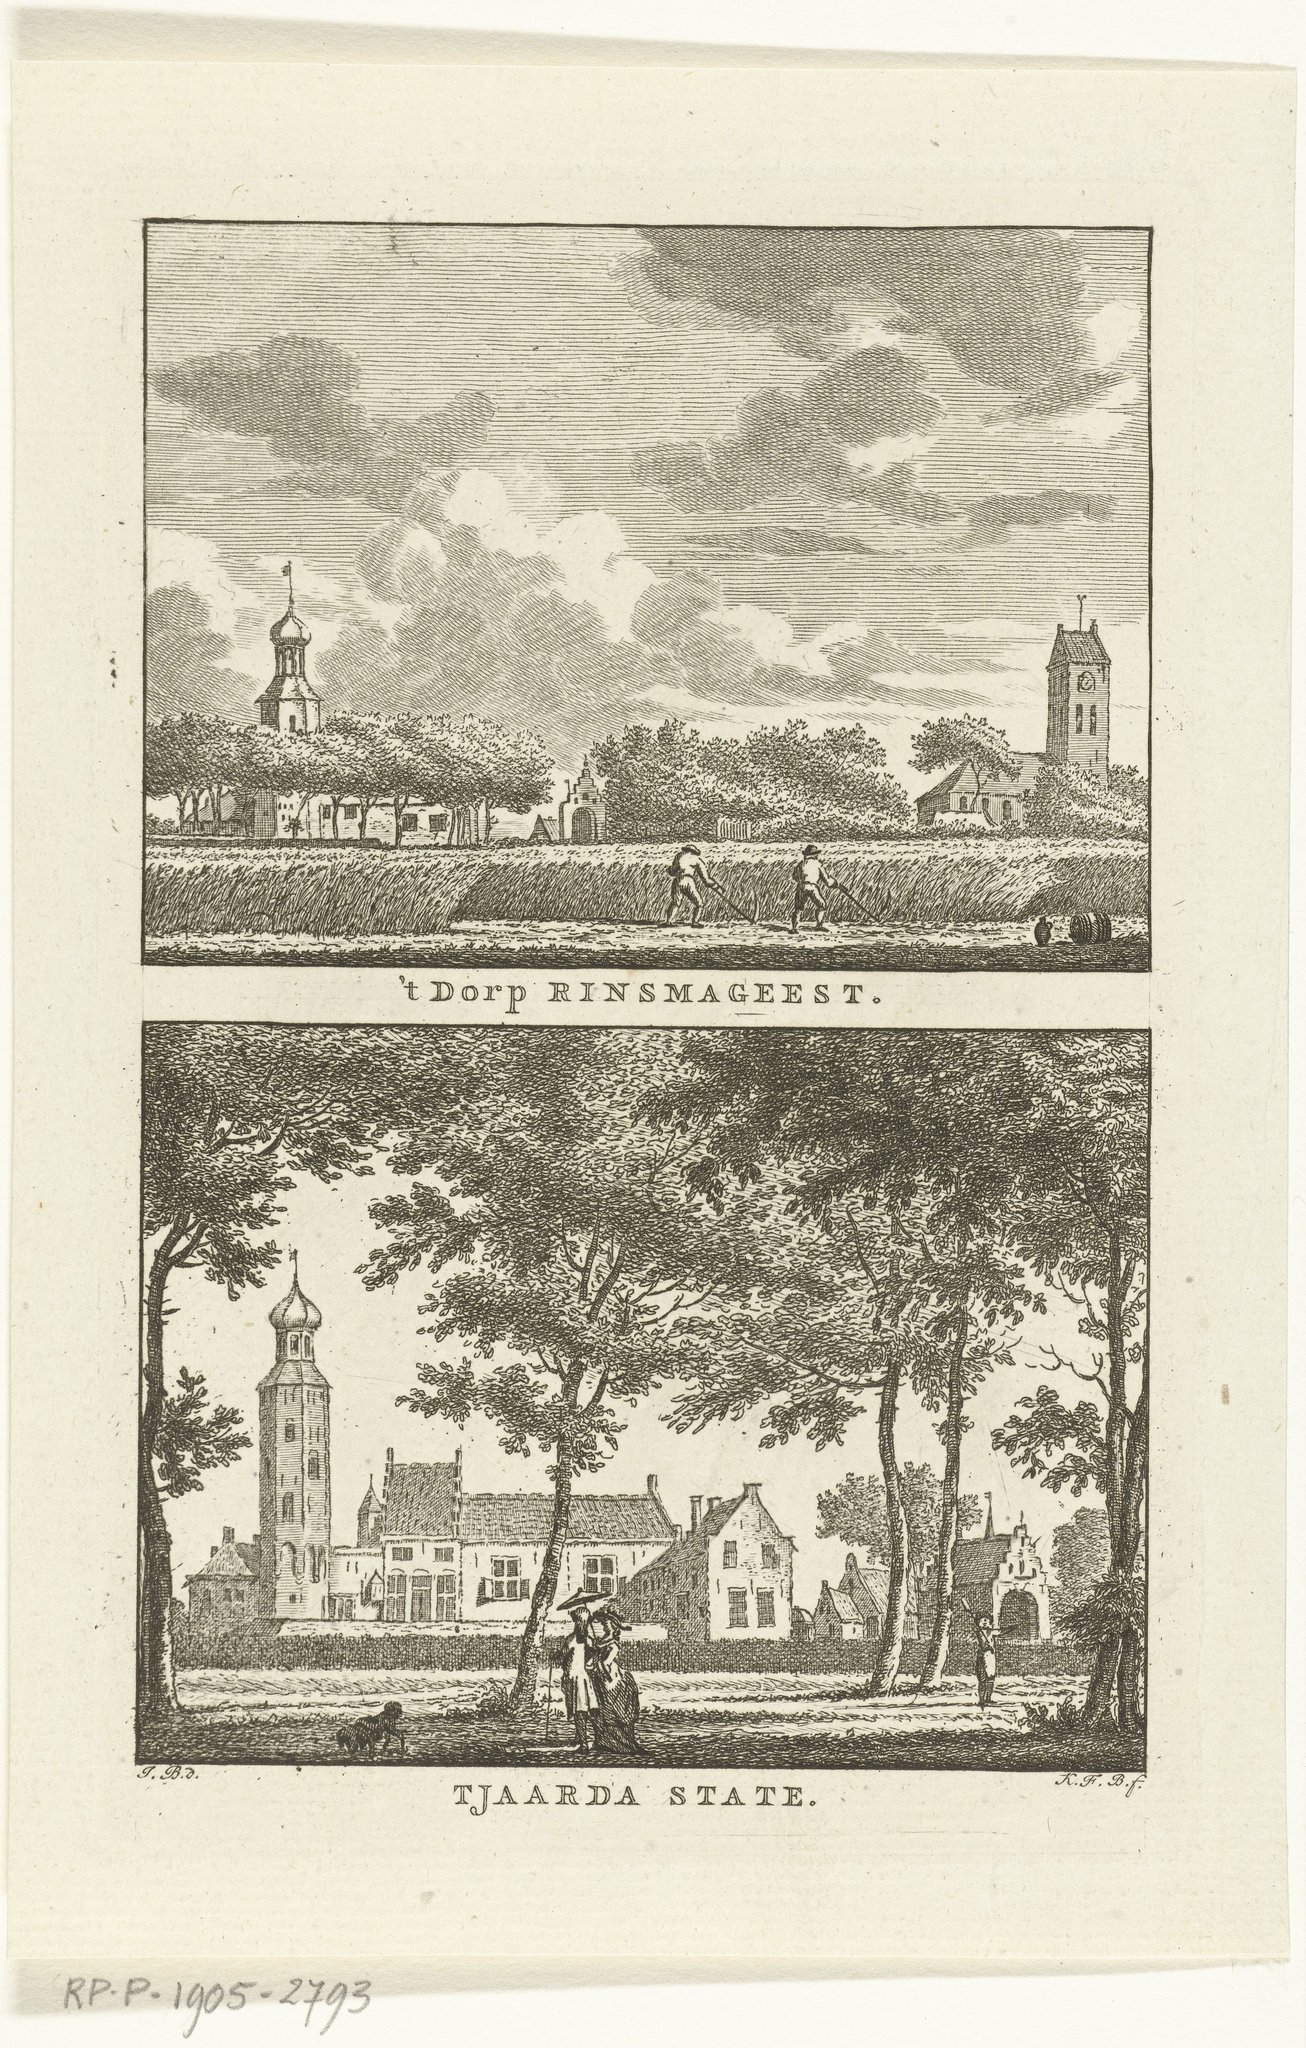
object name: print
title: 't Dorp Rinsmageest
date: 1786-1792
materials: paper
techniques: etching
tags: prospect of village, silhouette of village, country-house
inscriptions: collector's mark: Lugt 2228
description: Prent uit: Vaderlandsche gezichten, of afbeeldingen van den tegenwoordigen staat der Vereenigde Nederlanden (…). Amsterdam: Hendrik Gartman, Willem Vermandel en Jan Willem Smit, 1786-1792. Uitgegeven in afleveringen met ieder een eigen bifolium en inhoudsopgave. Alle prenten in deze publicatie zijn gegraveerd door Carel Frederik Bendorp (I) en, in de meeste gevallen, gebaseerd op tekeningen van Jan Bulthuis.